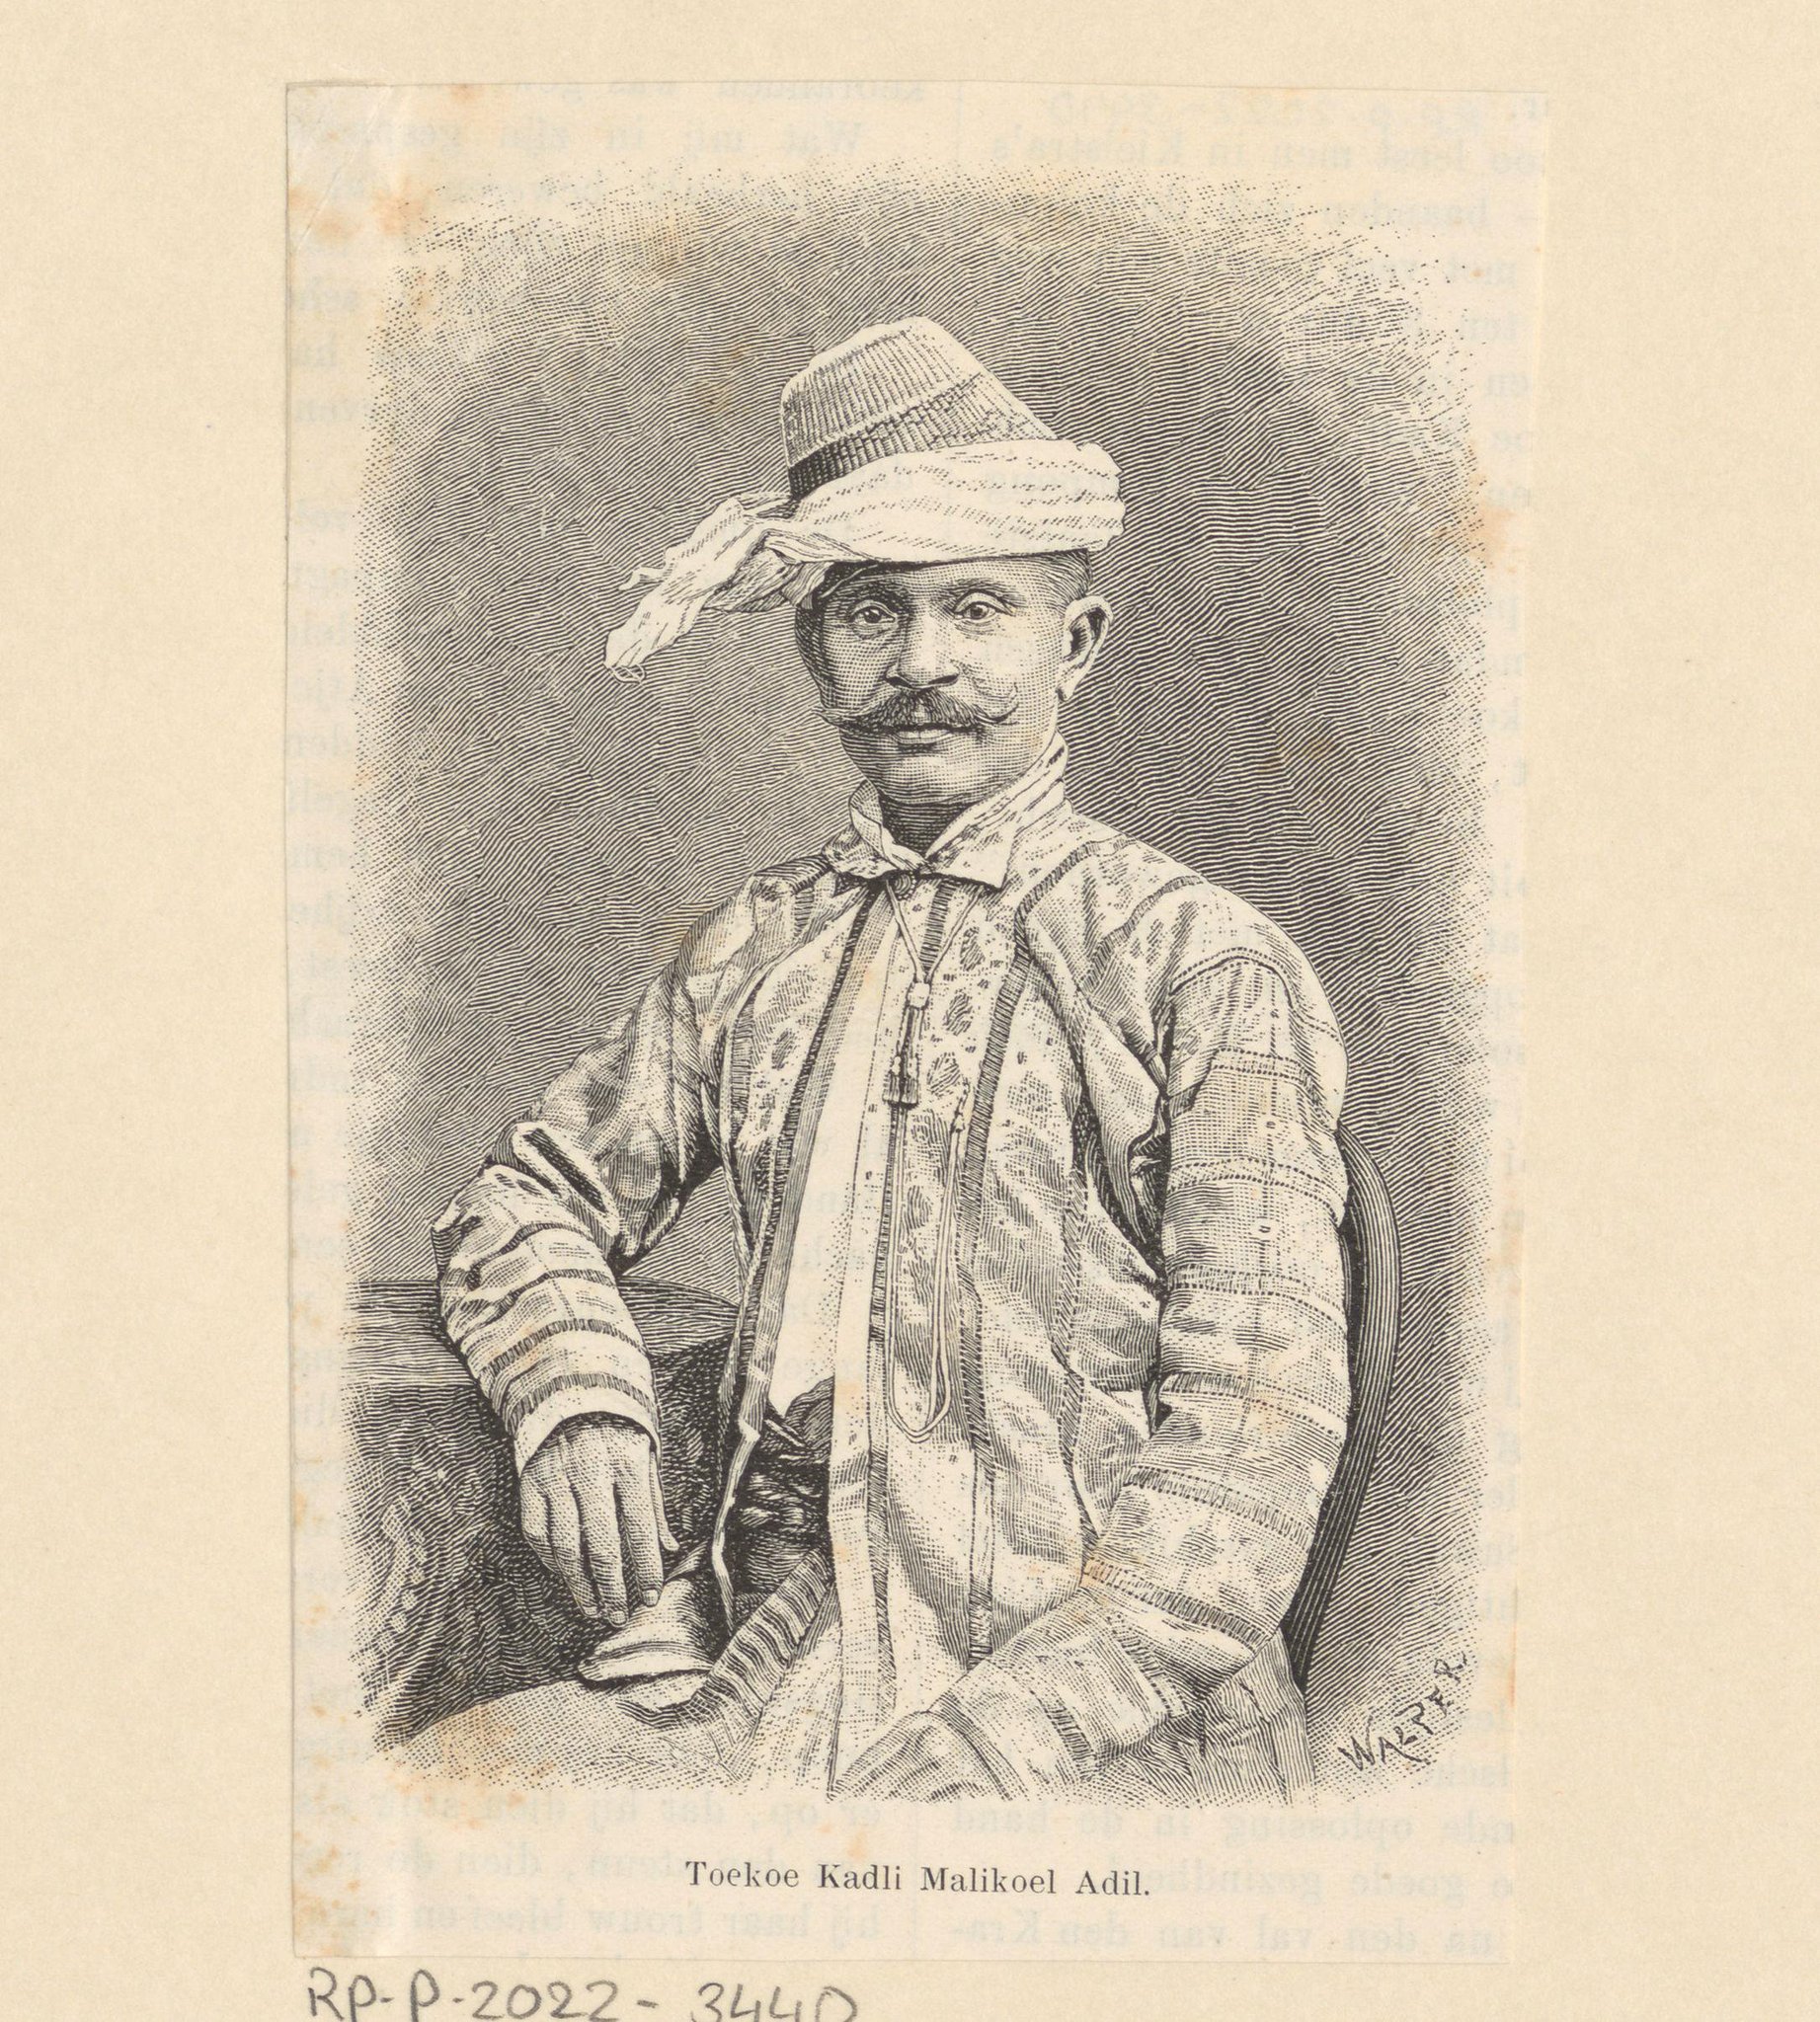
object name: print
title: Portret van Toekoe Kadli Malikoel Adil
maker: Anonymous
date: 1888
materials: paper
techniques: letterpress printing, engraving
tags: historical persons, ruler, sovereign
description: Prent uit: Eigen Haard (1888), nr. 1, p. 81.